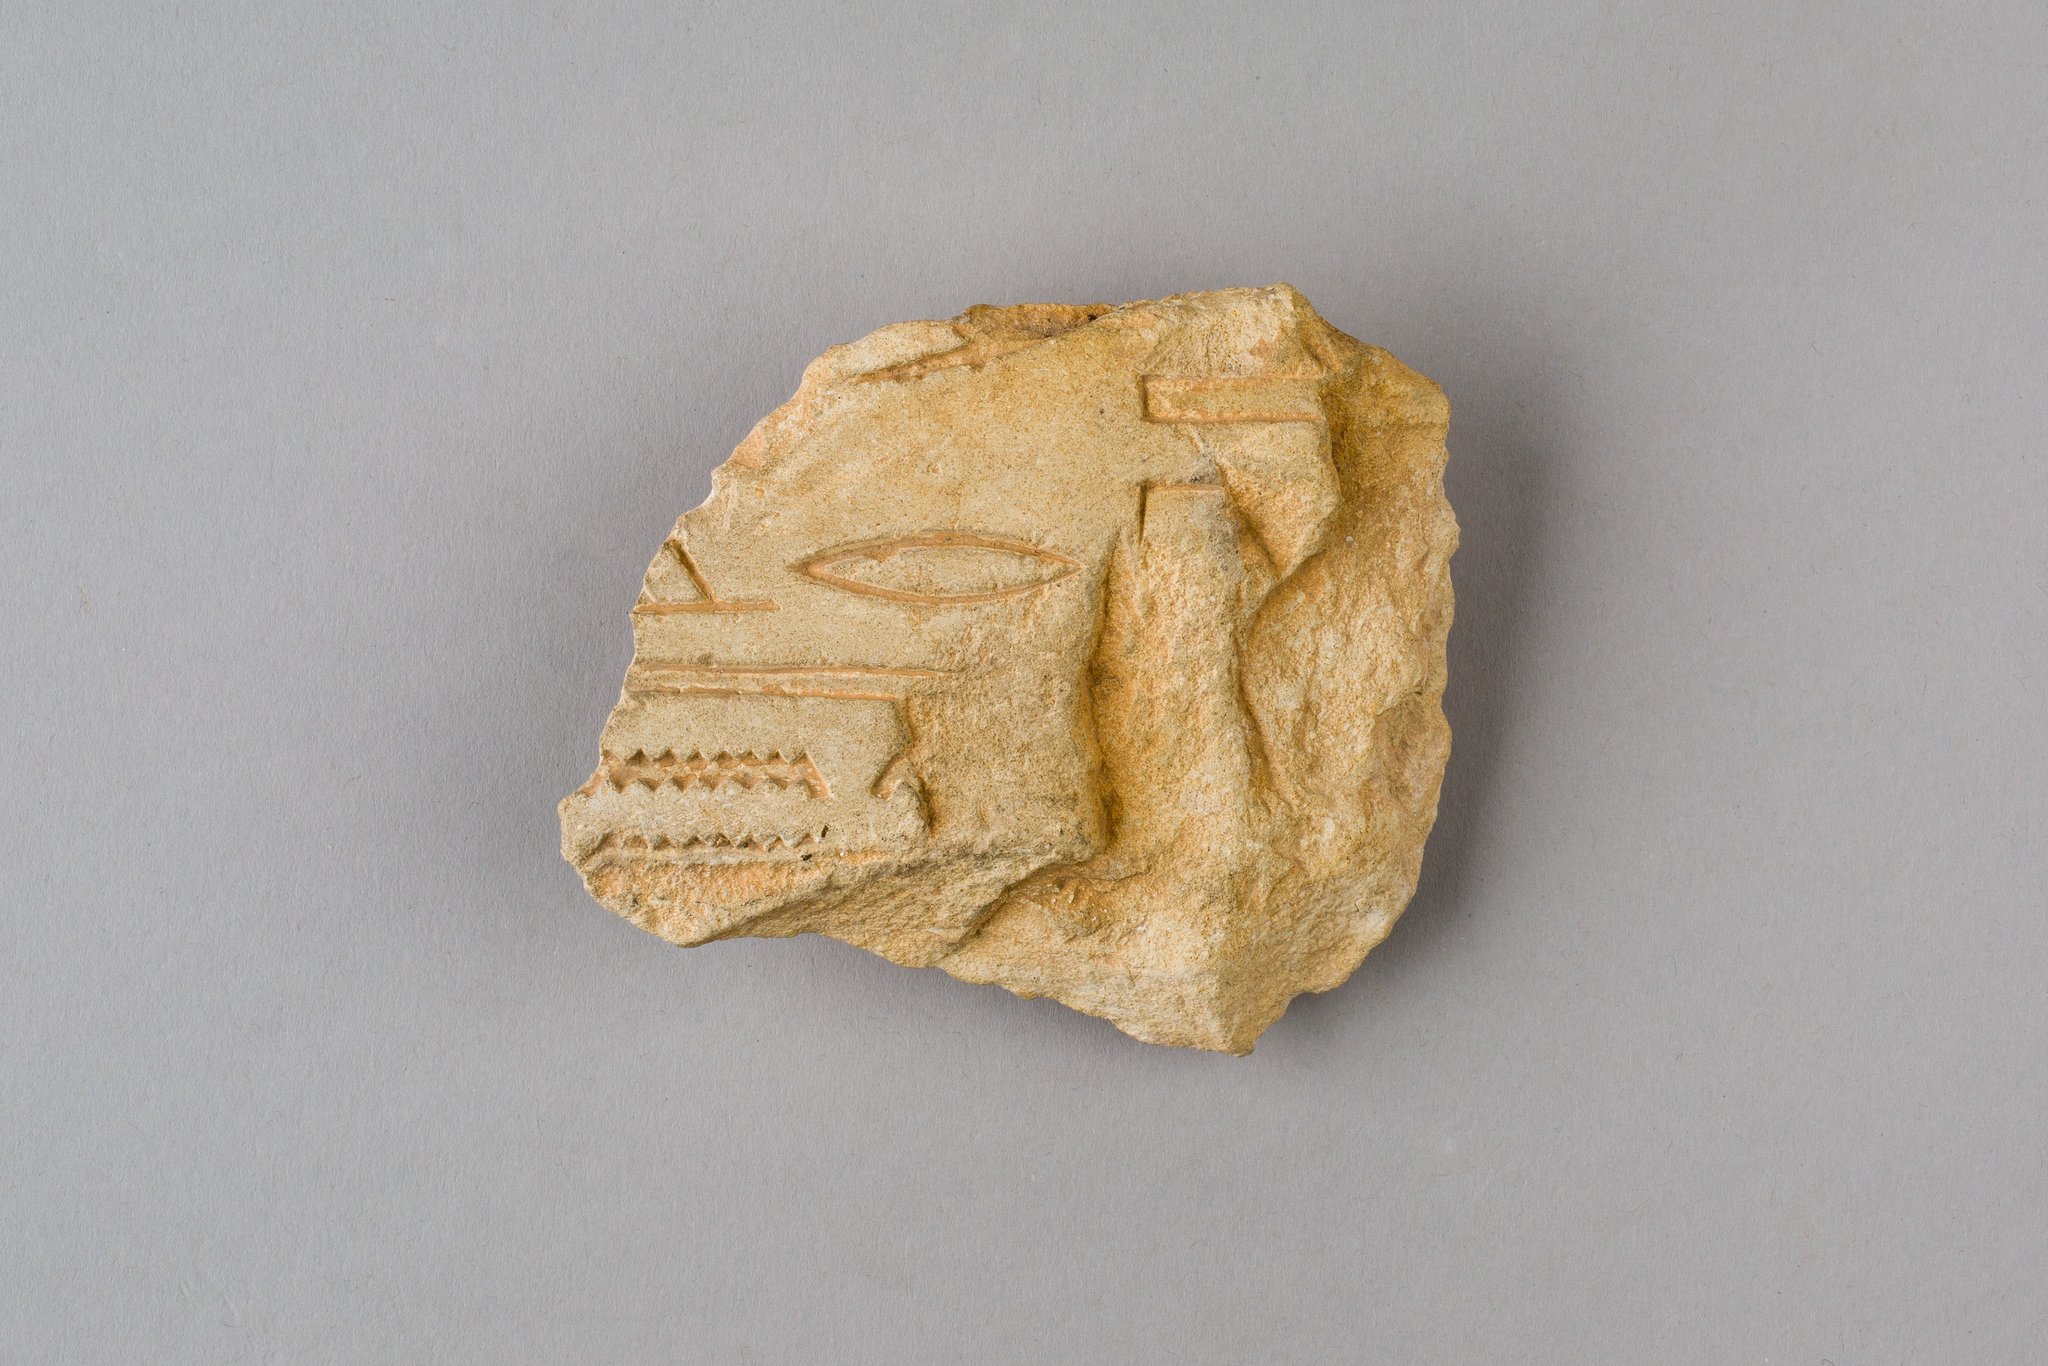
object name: stela, henenu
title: Relief Fragments from the Henenu Stela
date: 2030-2000 BCE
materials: limestone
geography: egypt